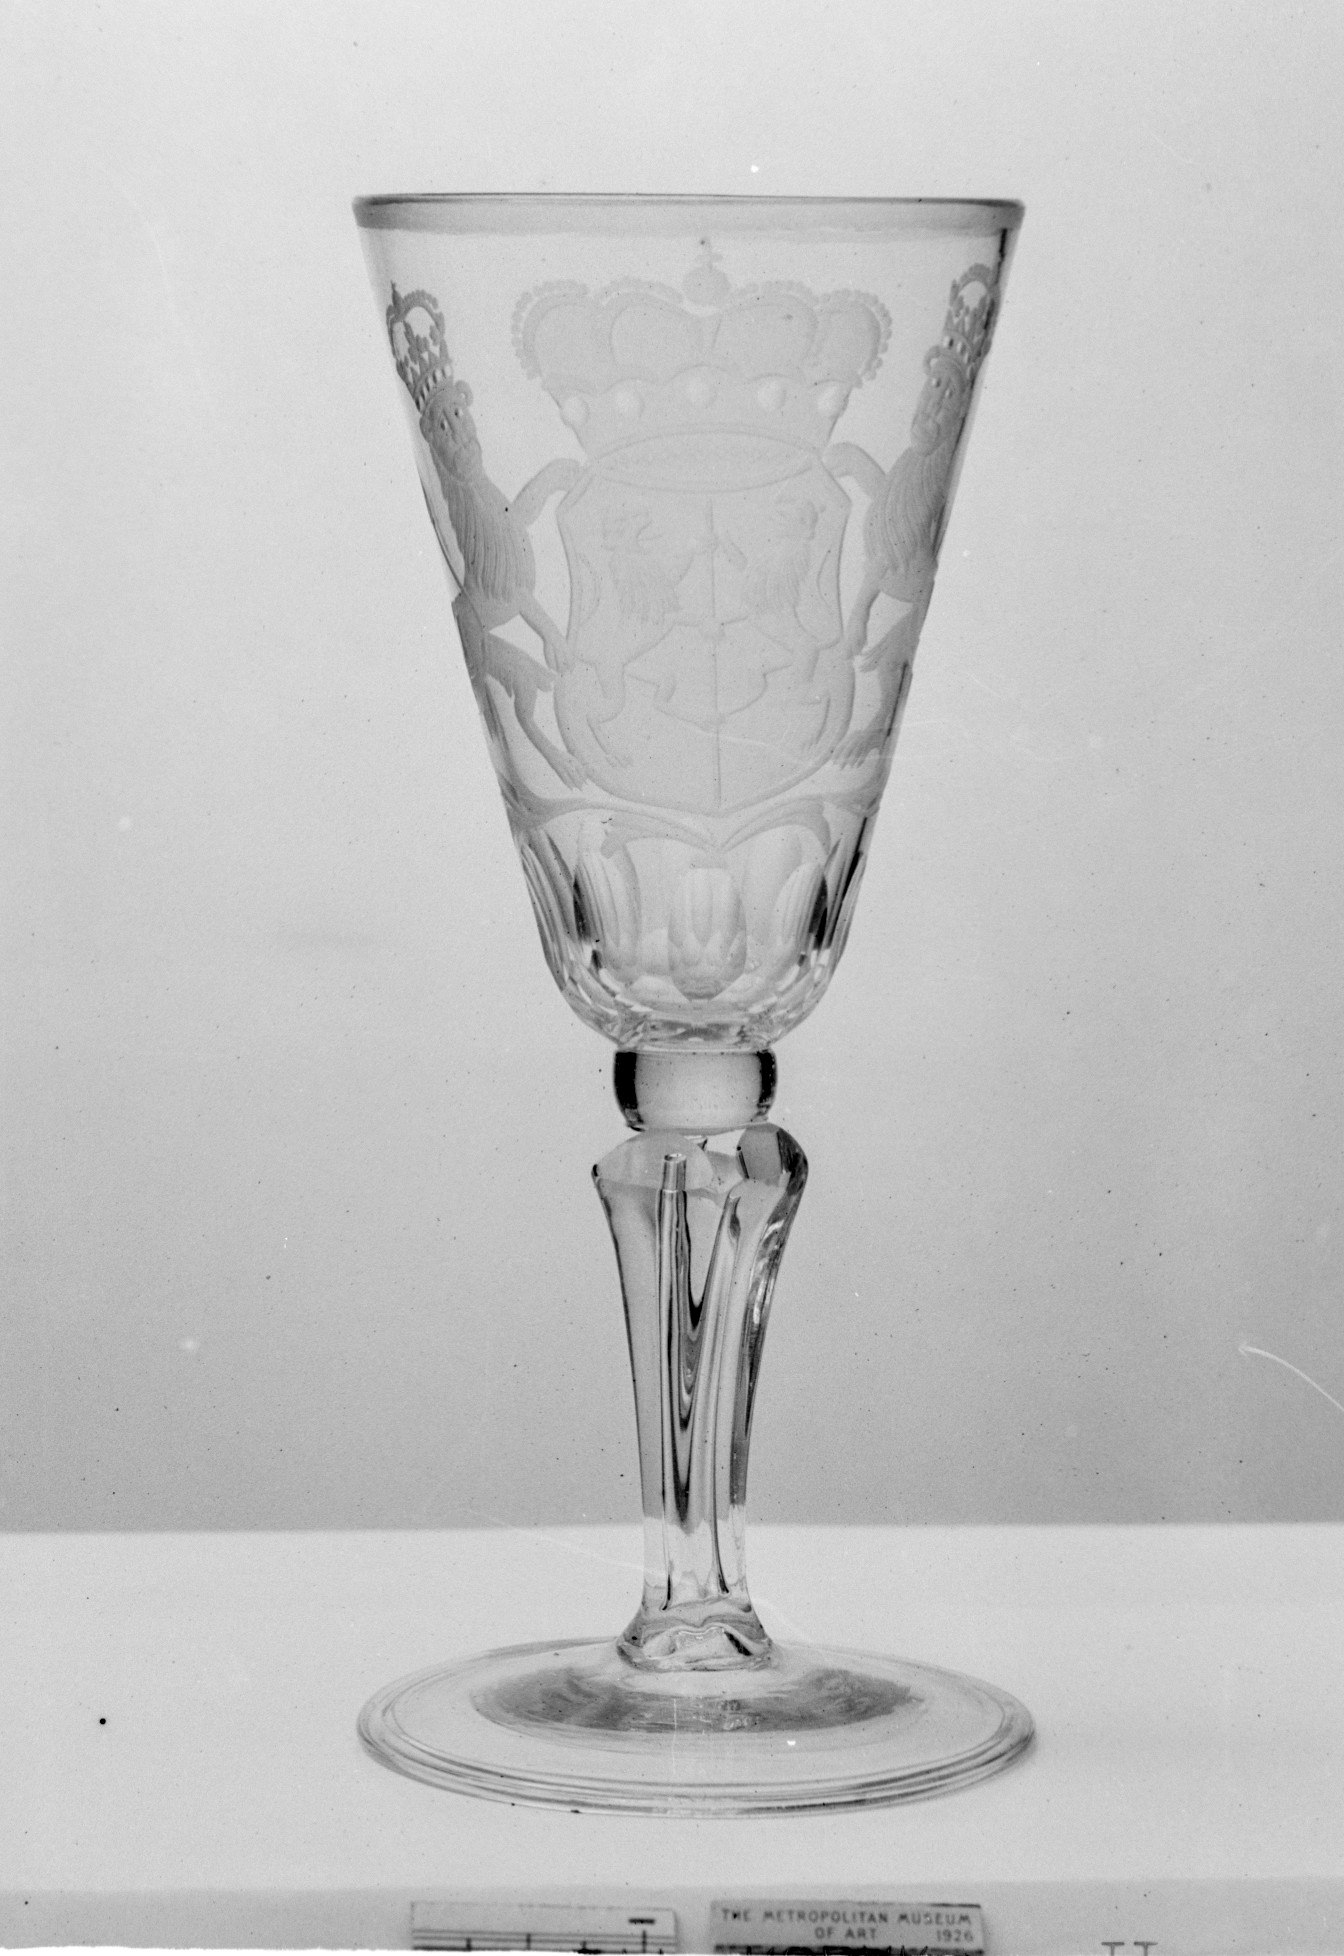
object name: wineglass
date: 1720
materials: glass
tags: coat of arms